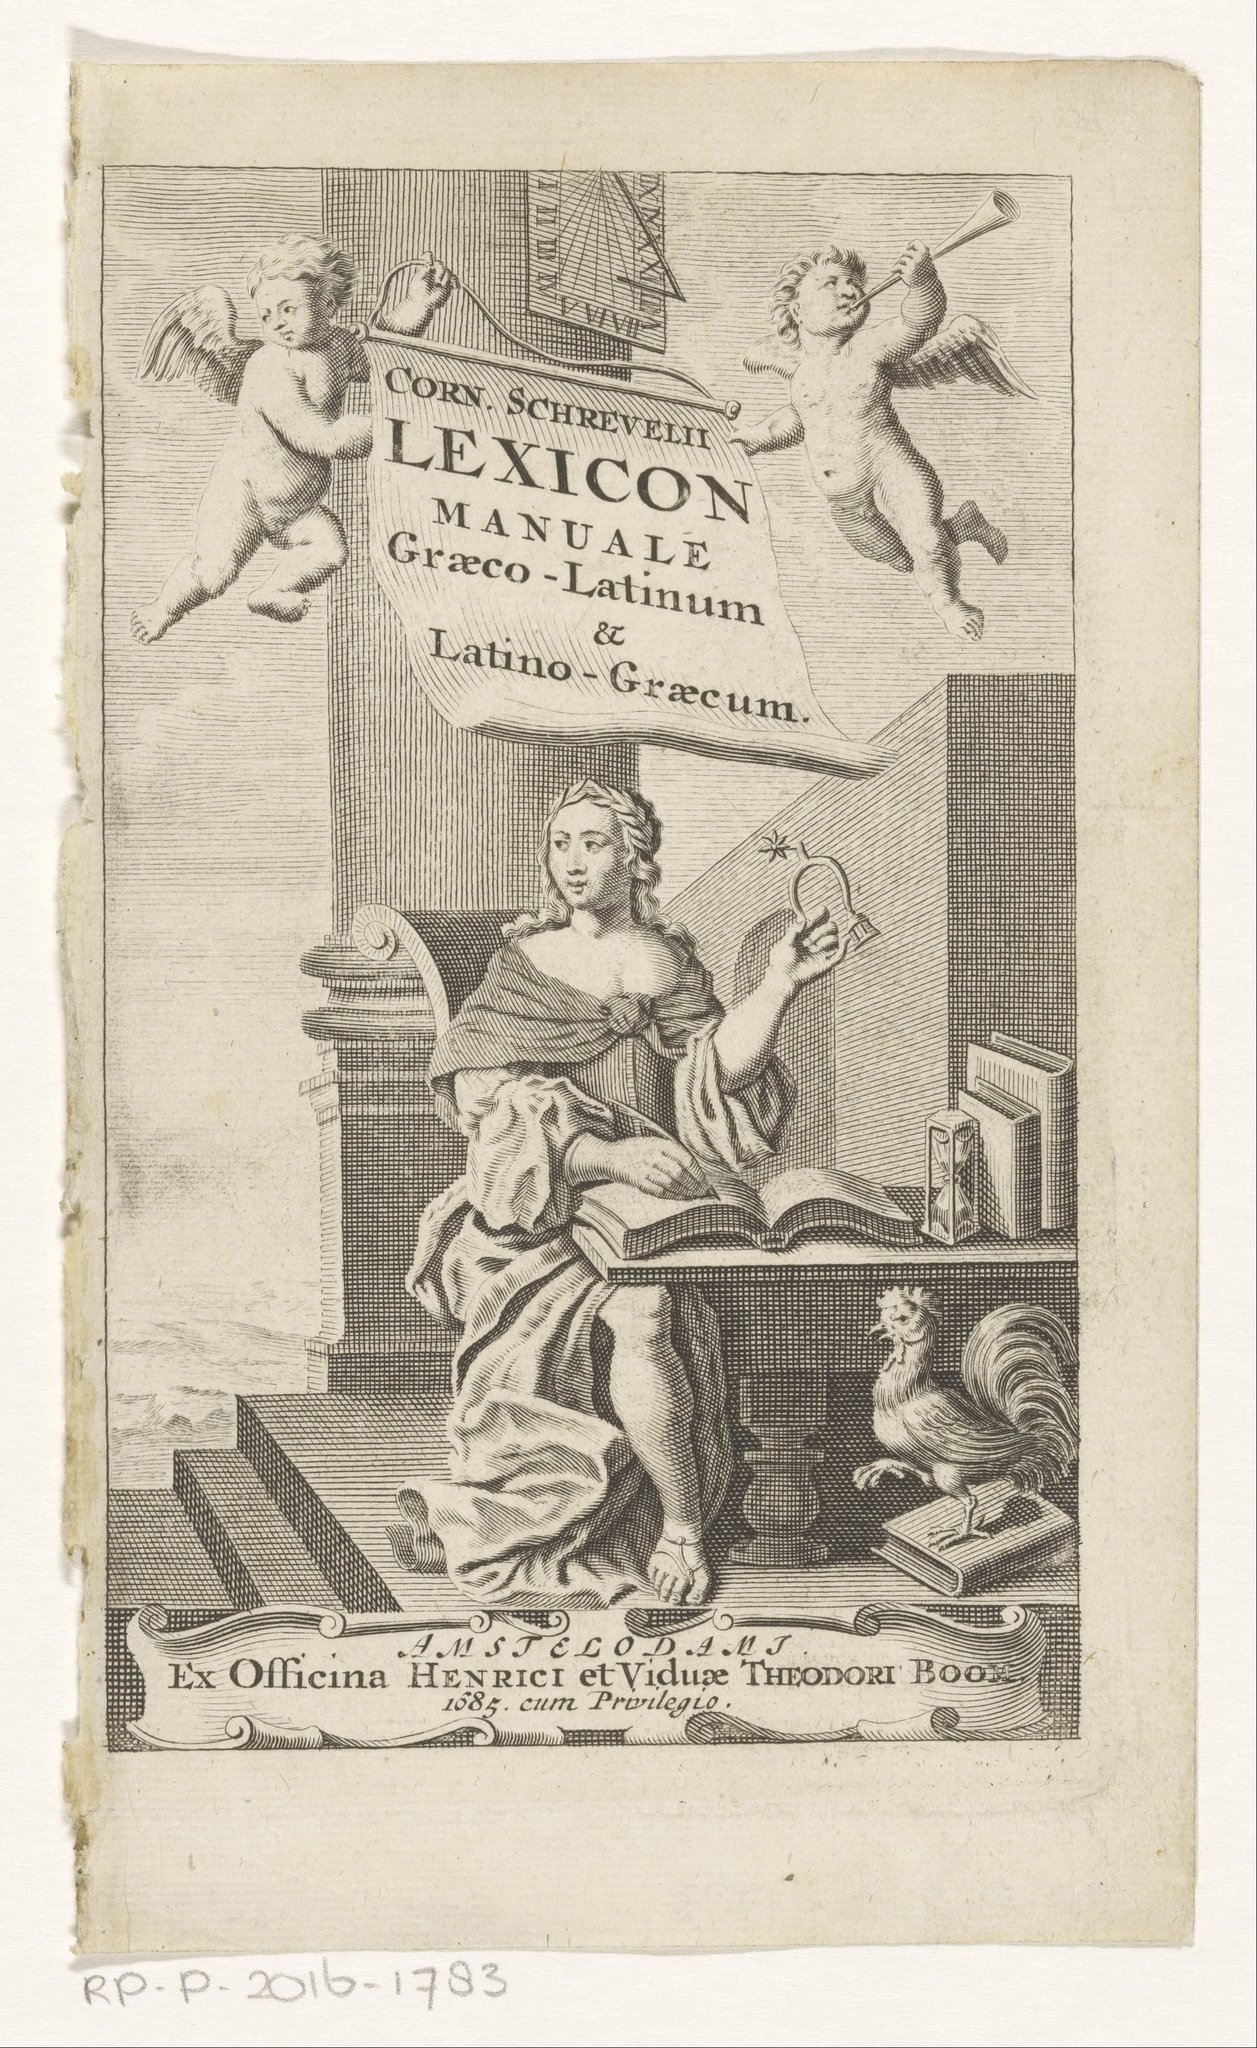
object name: print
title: Titelpagina voor: Cornelis Schrevelius, Lexicon manuale Graeco-Latinum, 1685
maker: Anonymous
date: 1685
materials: paper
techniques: engraving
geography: amsterdam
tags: writing-table, writing-desk, spur, reason; 'ragione' (ripa)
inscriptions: collector's mark: Lugt 2228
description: Een vrouw, in klassiek gewaad, zittend achter een schrijftafel, in de hand een spoor, als verwijzing naar de rede. Op de tafel een zandloper, als symbool voor vergankelijkheid. Aan haar voeten een haan, als symbool voor waakzaamheid. Op de zuil achter haar een zonnewijzer, die verwijst naar het verstrijken van de tijd. Twee engelen houden een banier vast waarop de titel in het Latijn.